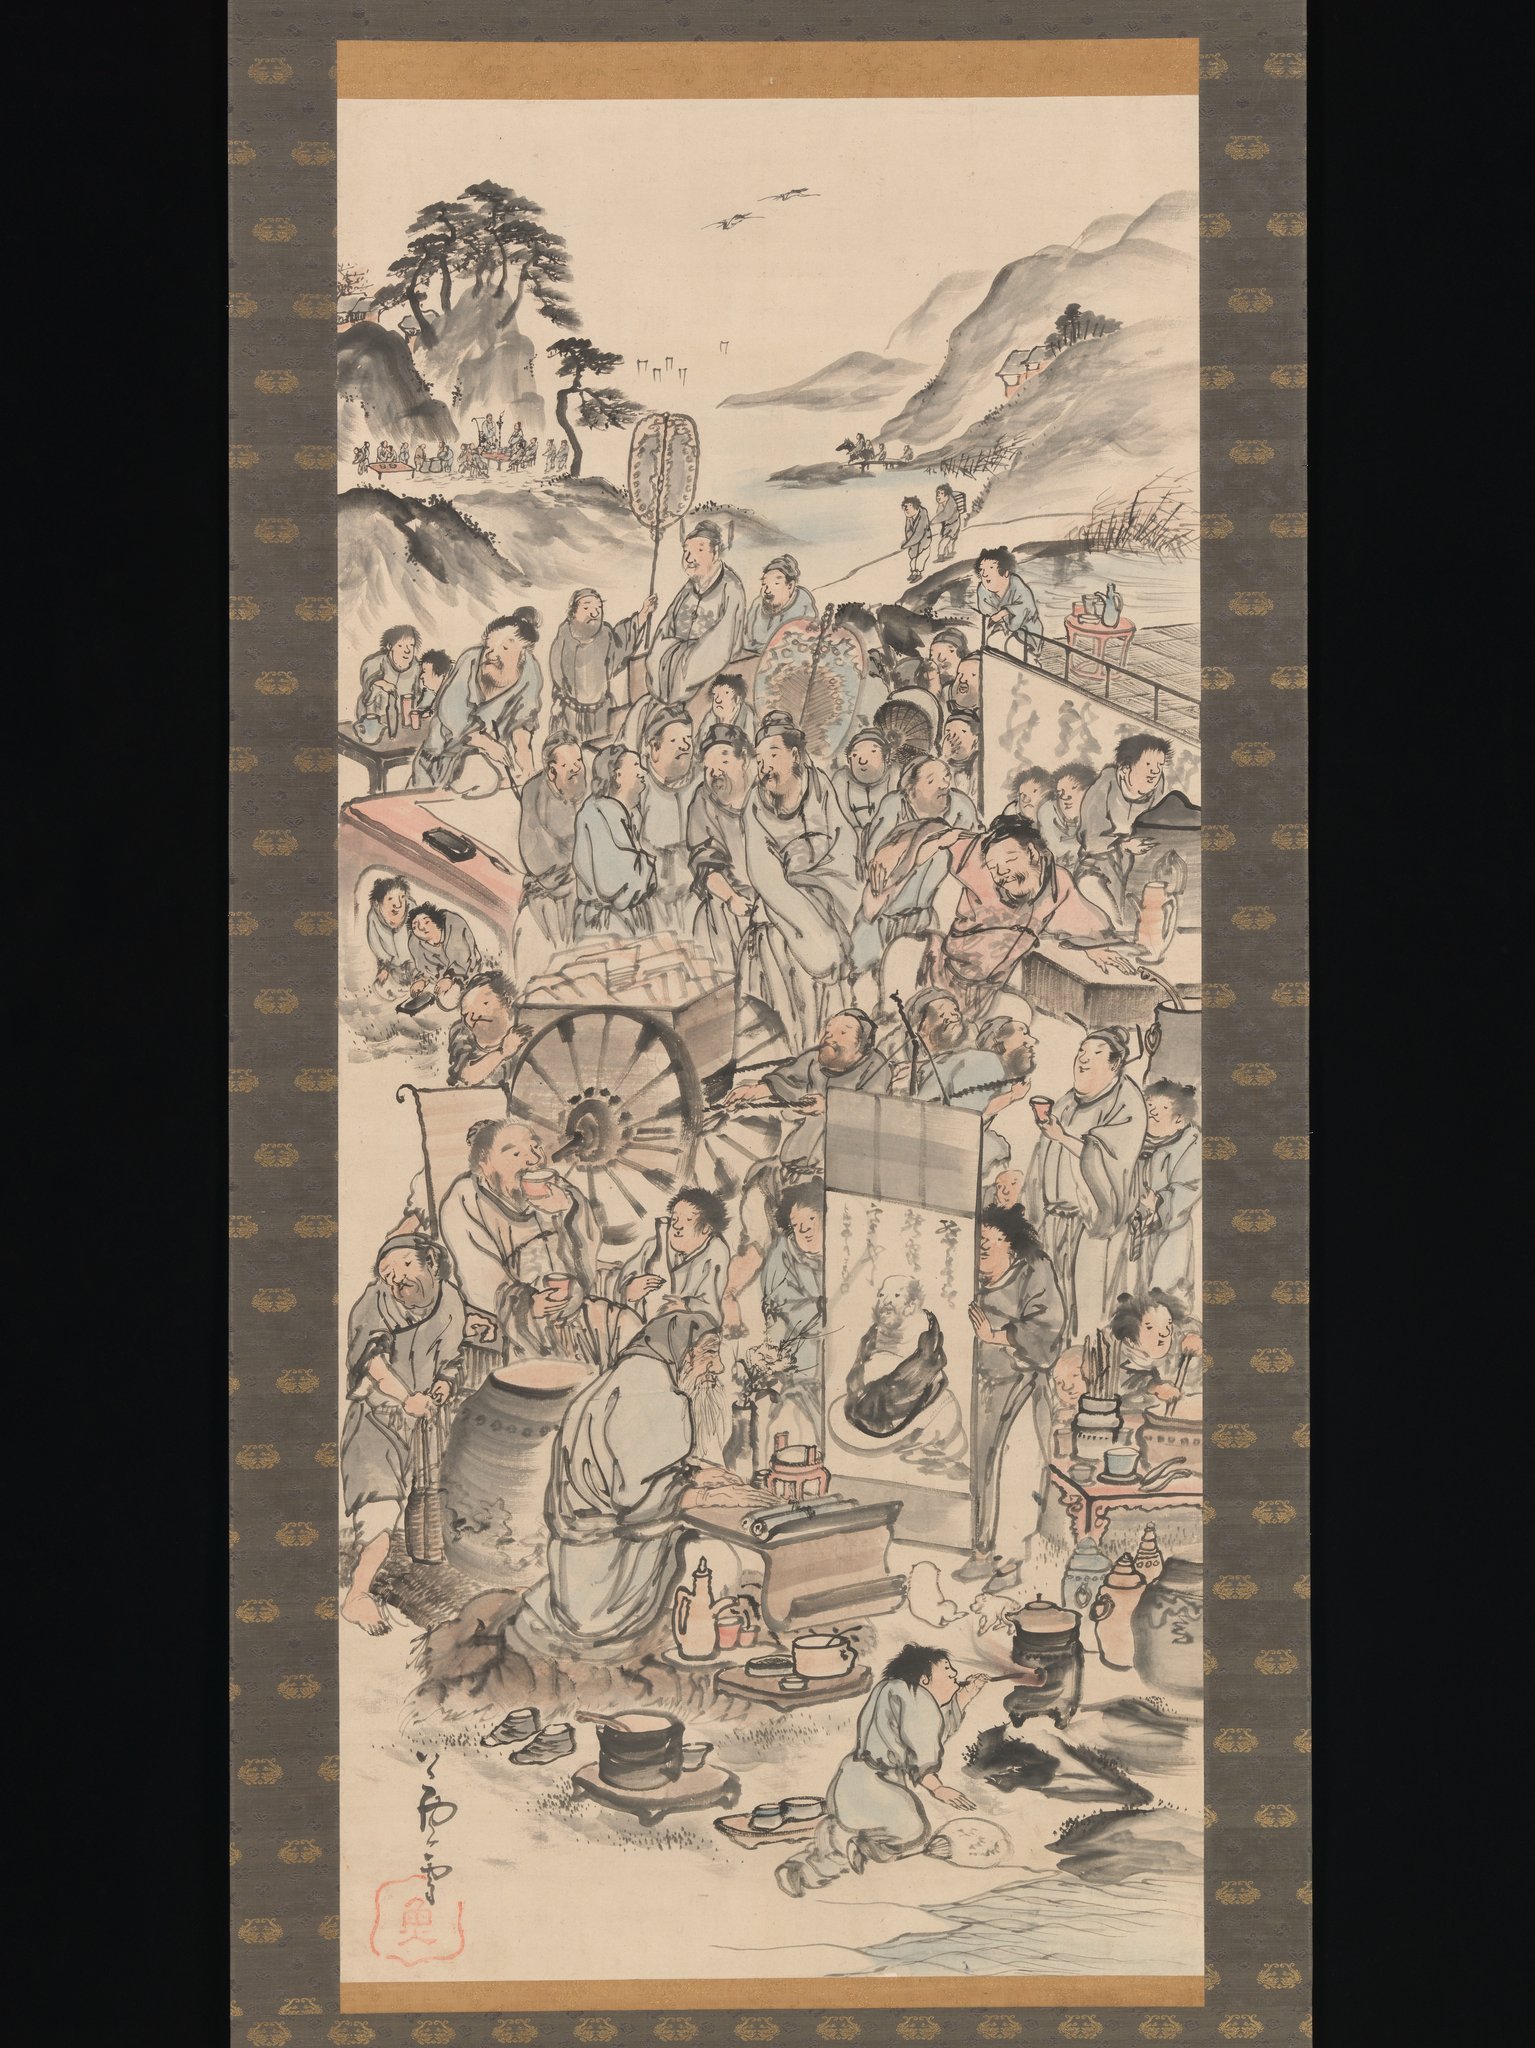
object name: hanging scroll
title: Drinking Festival of the Eight Immortals of the Wine Cup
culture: japanese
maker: nagasawa rosetsu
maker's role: artist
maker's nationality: japanese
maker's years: 1754-1799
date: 1767-1800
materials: ink, paper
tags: crowd,drinking